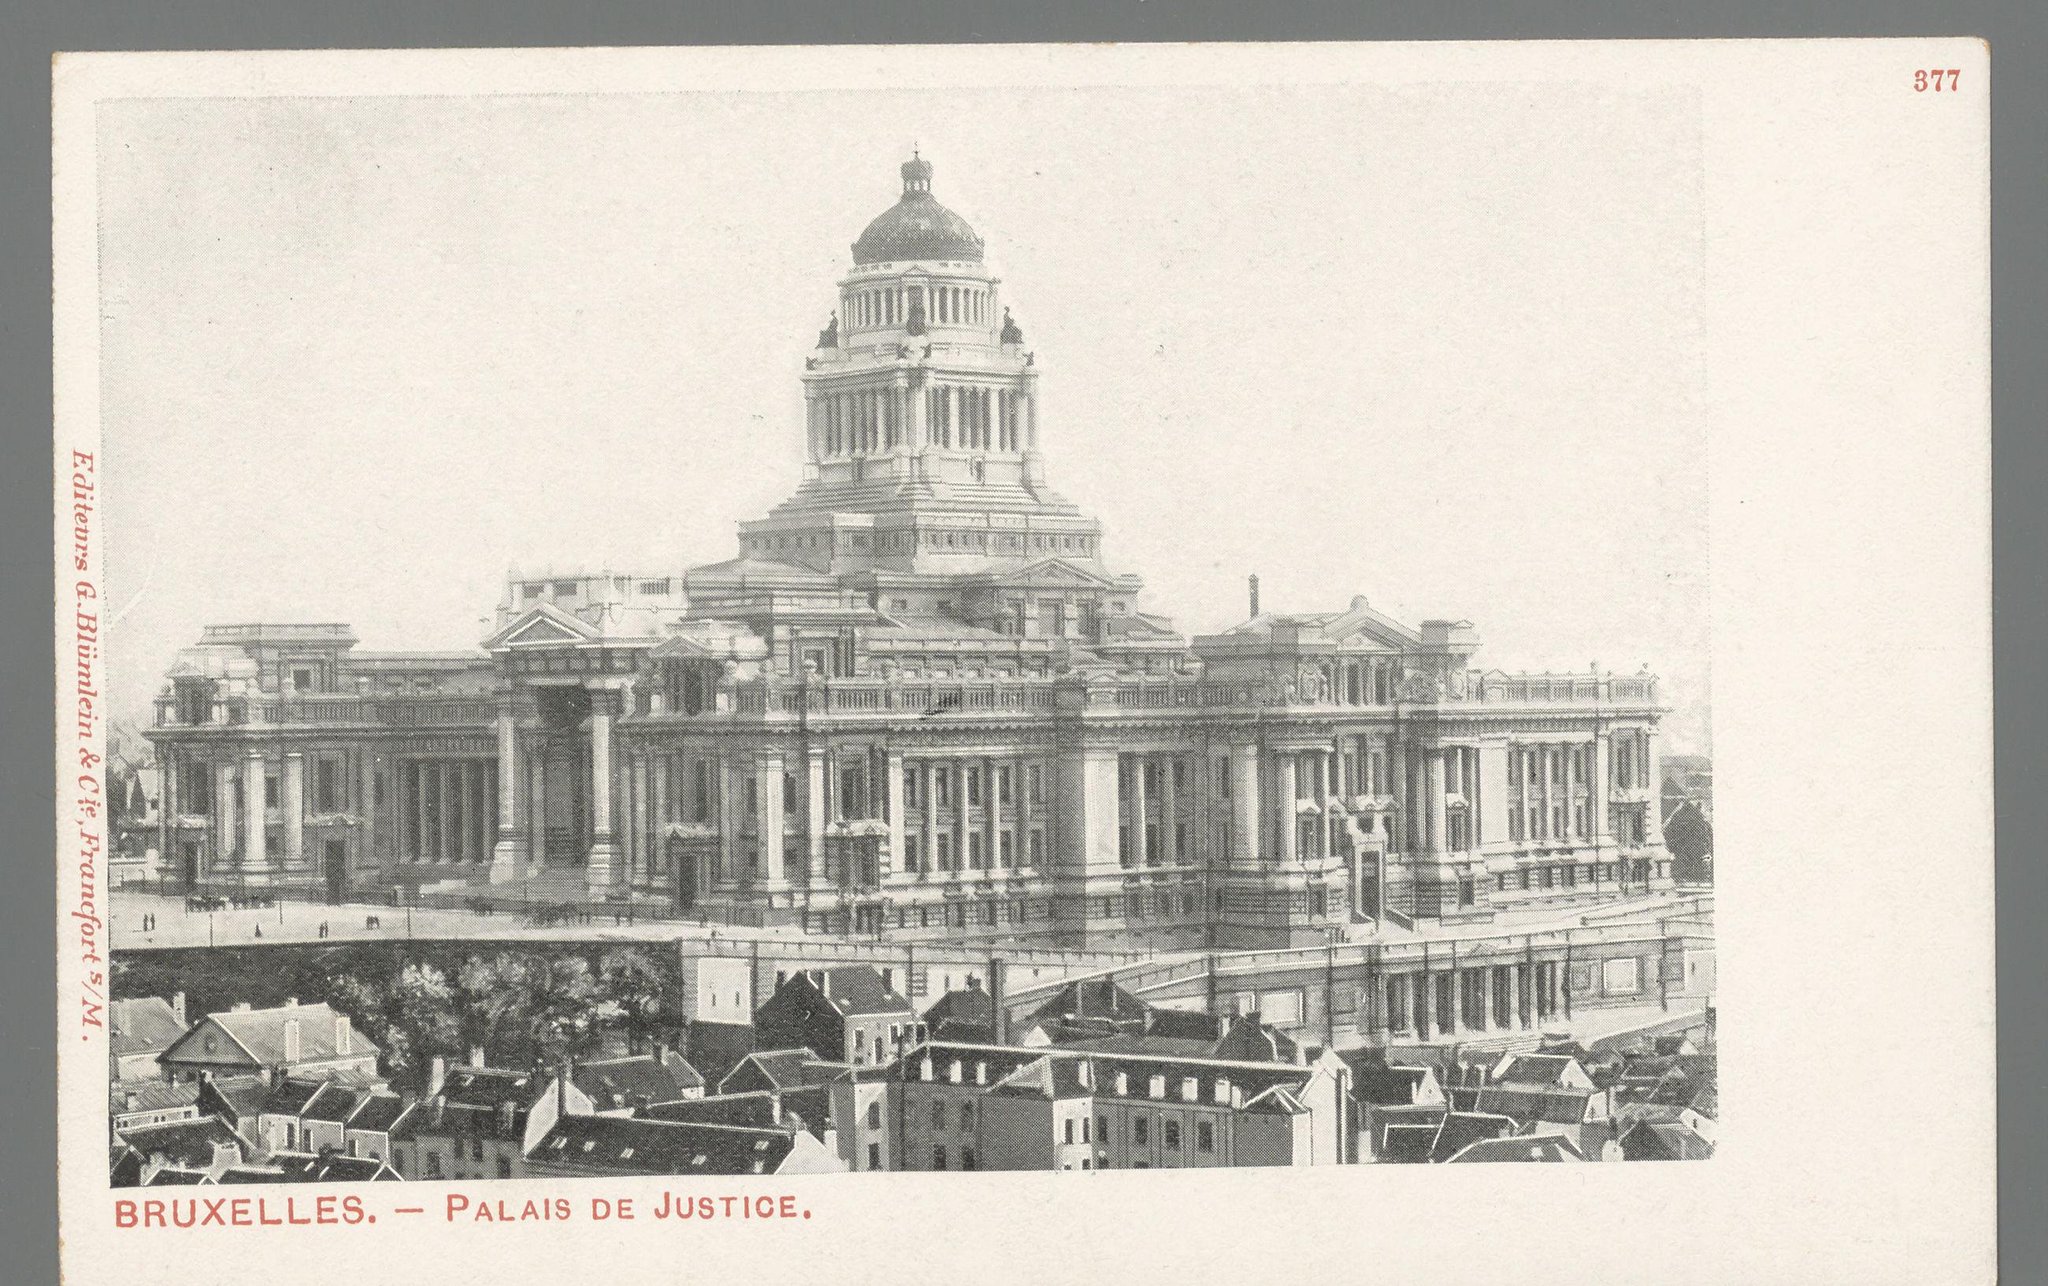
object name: ansichtkaart, prentbriefkaart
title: Bruxelles. Palais de Justice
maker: Anonymous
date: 1894-1906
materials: cardboard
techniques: autotype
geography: frankfurt am main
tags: court building, city-view, and landscape with man-made constructions